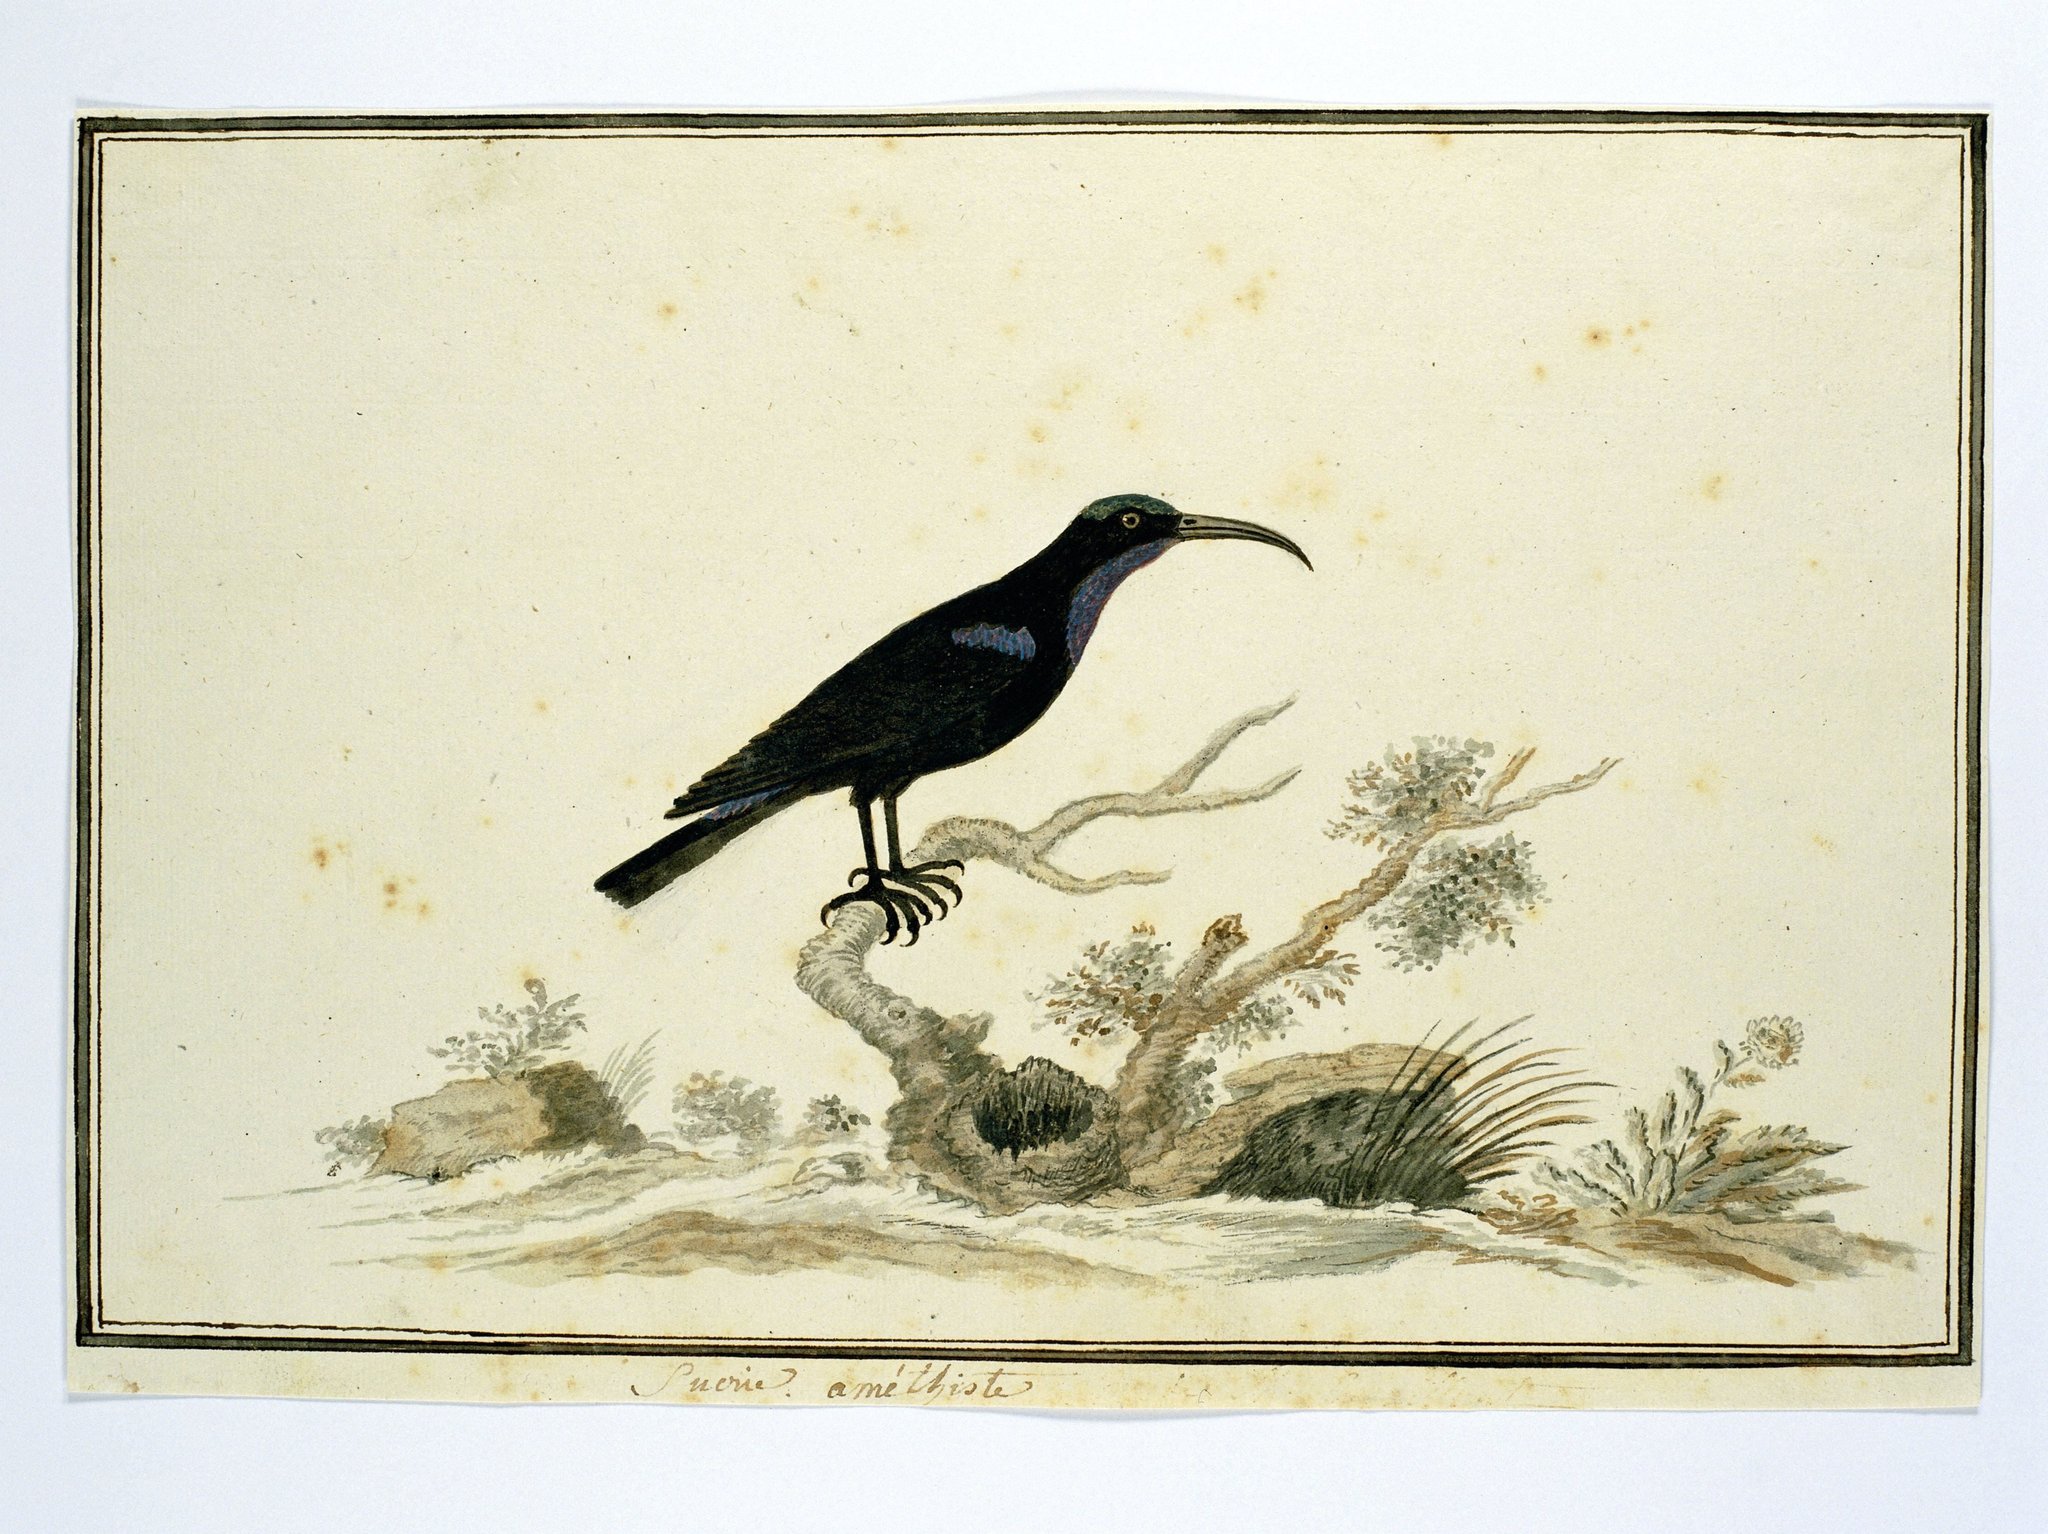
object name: album leaf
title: Nectarinia amethystina (Amethyst sunbird)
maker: robert jacob gordon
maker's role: draughtsman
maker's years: 1743-1795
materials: paint, ink, paper, pencil, watercolor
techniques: brush, pen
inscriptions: annotation: ‘Sucrie améthiste’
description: Black sunbird (Eng.). Franse benaming (titel) geschreven door Levaillant.